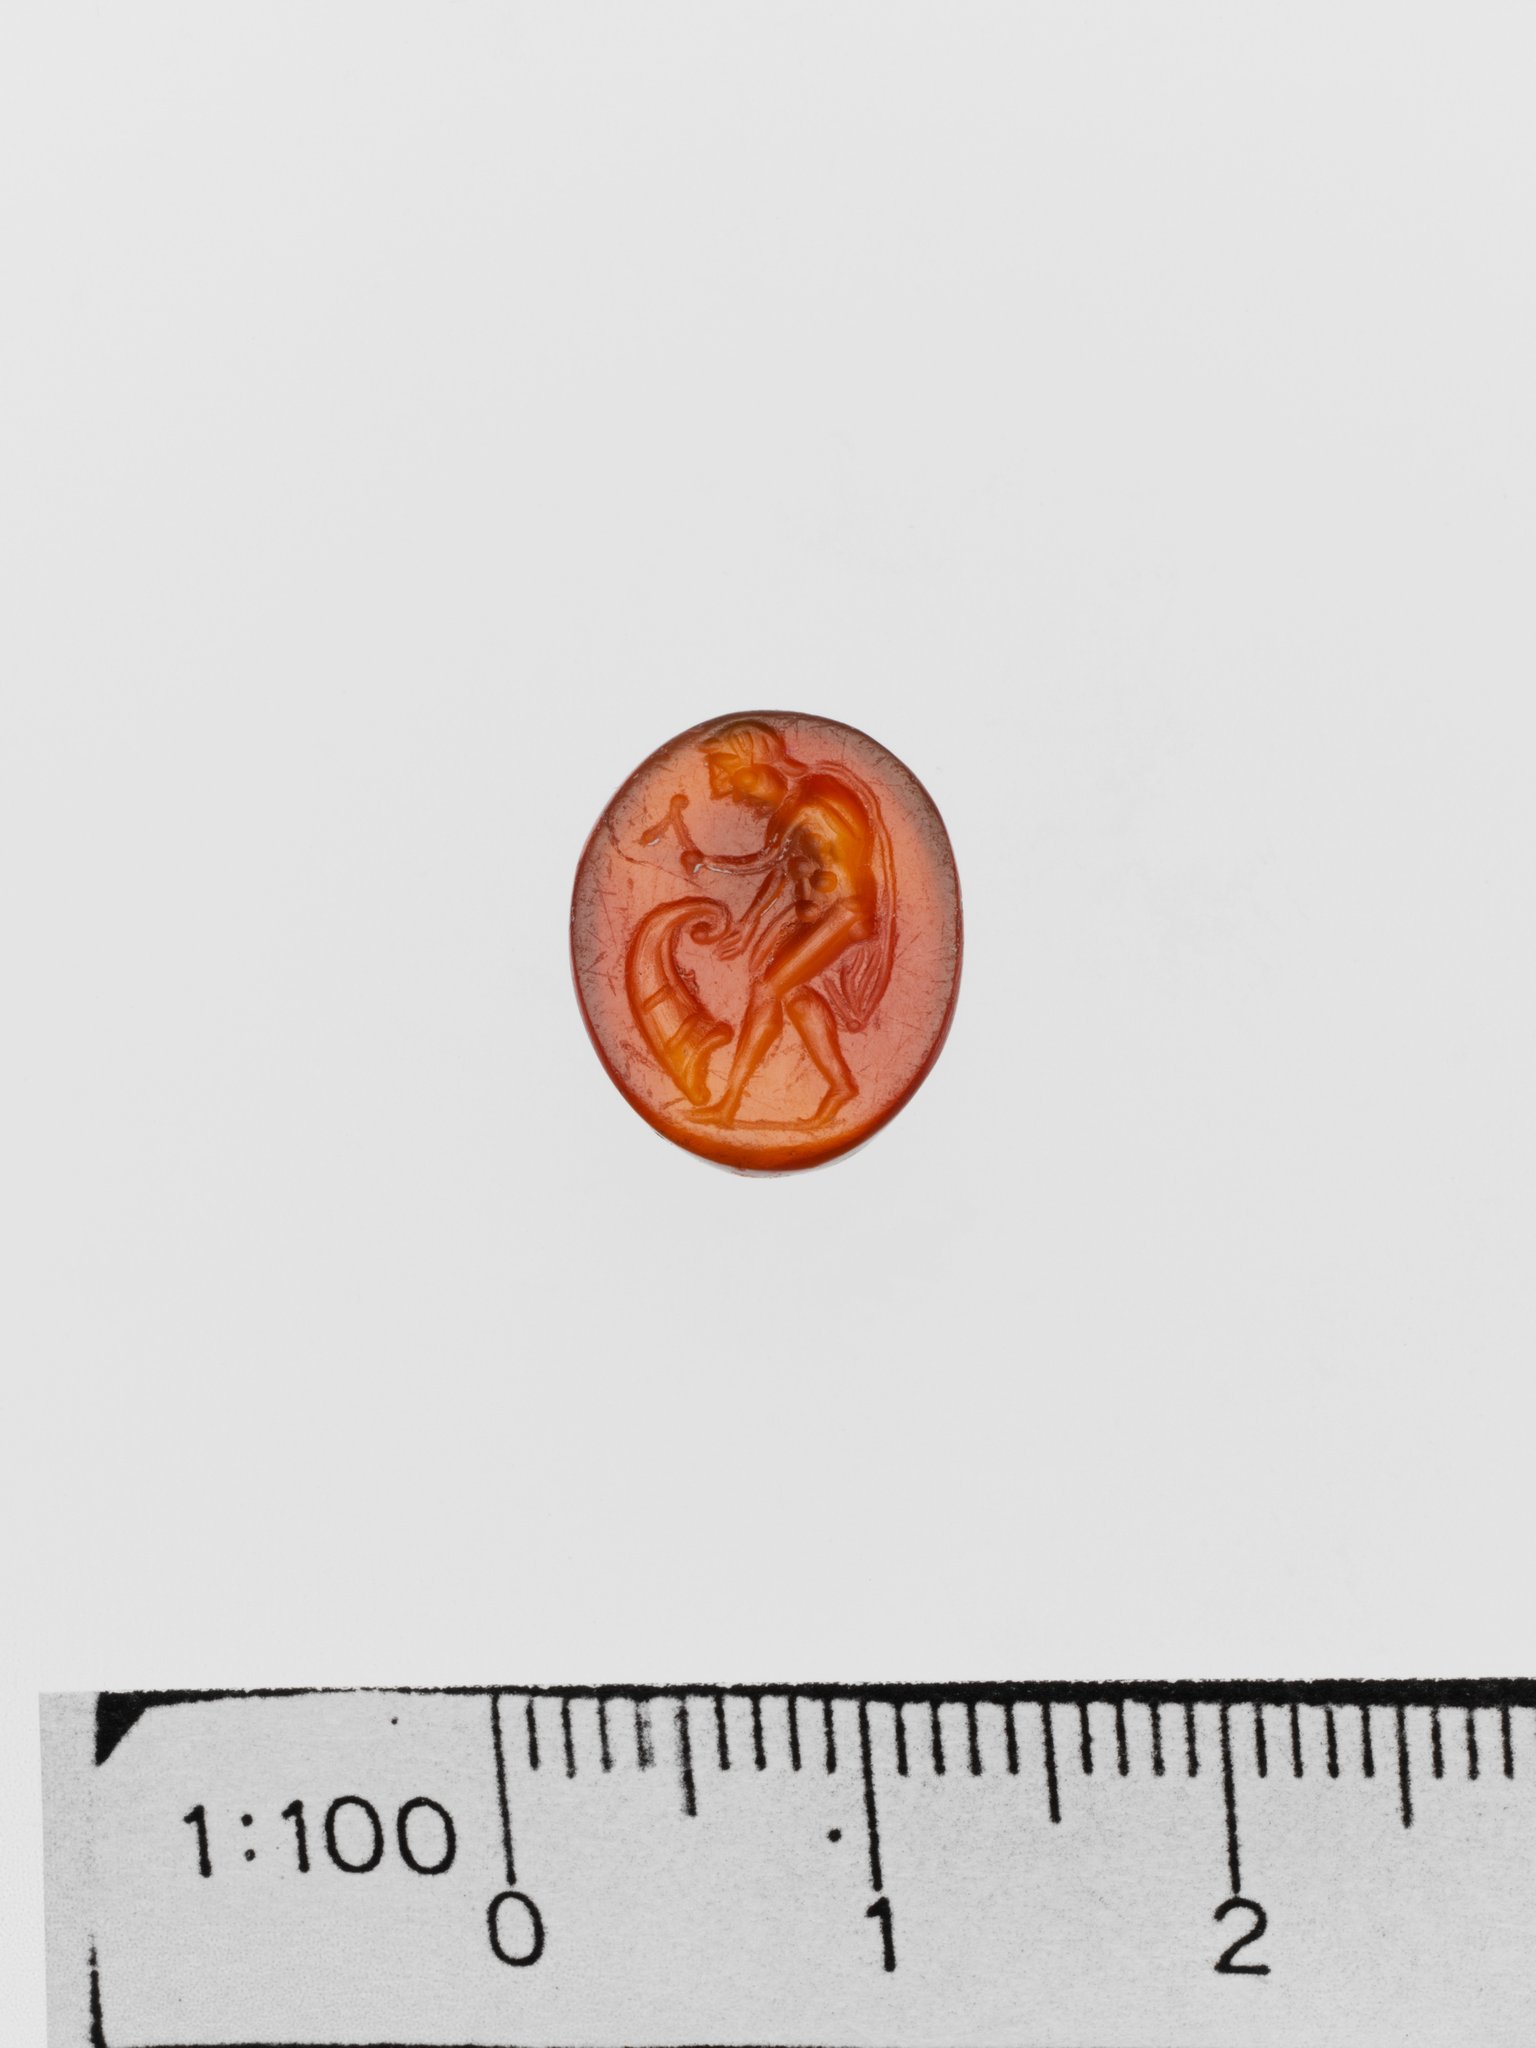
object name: intaglio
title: Carnelian ring stone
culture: italic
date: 300-101 BCE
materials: gemstone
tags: men,working